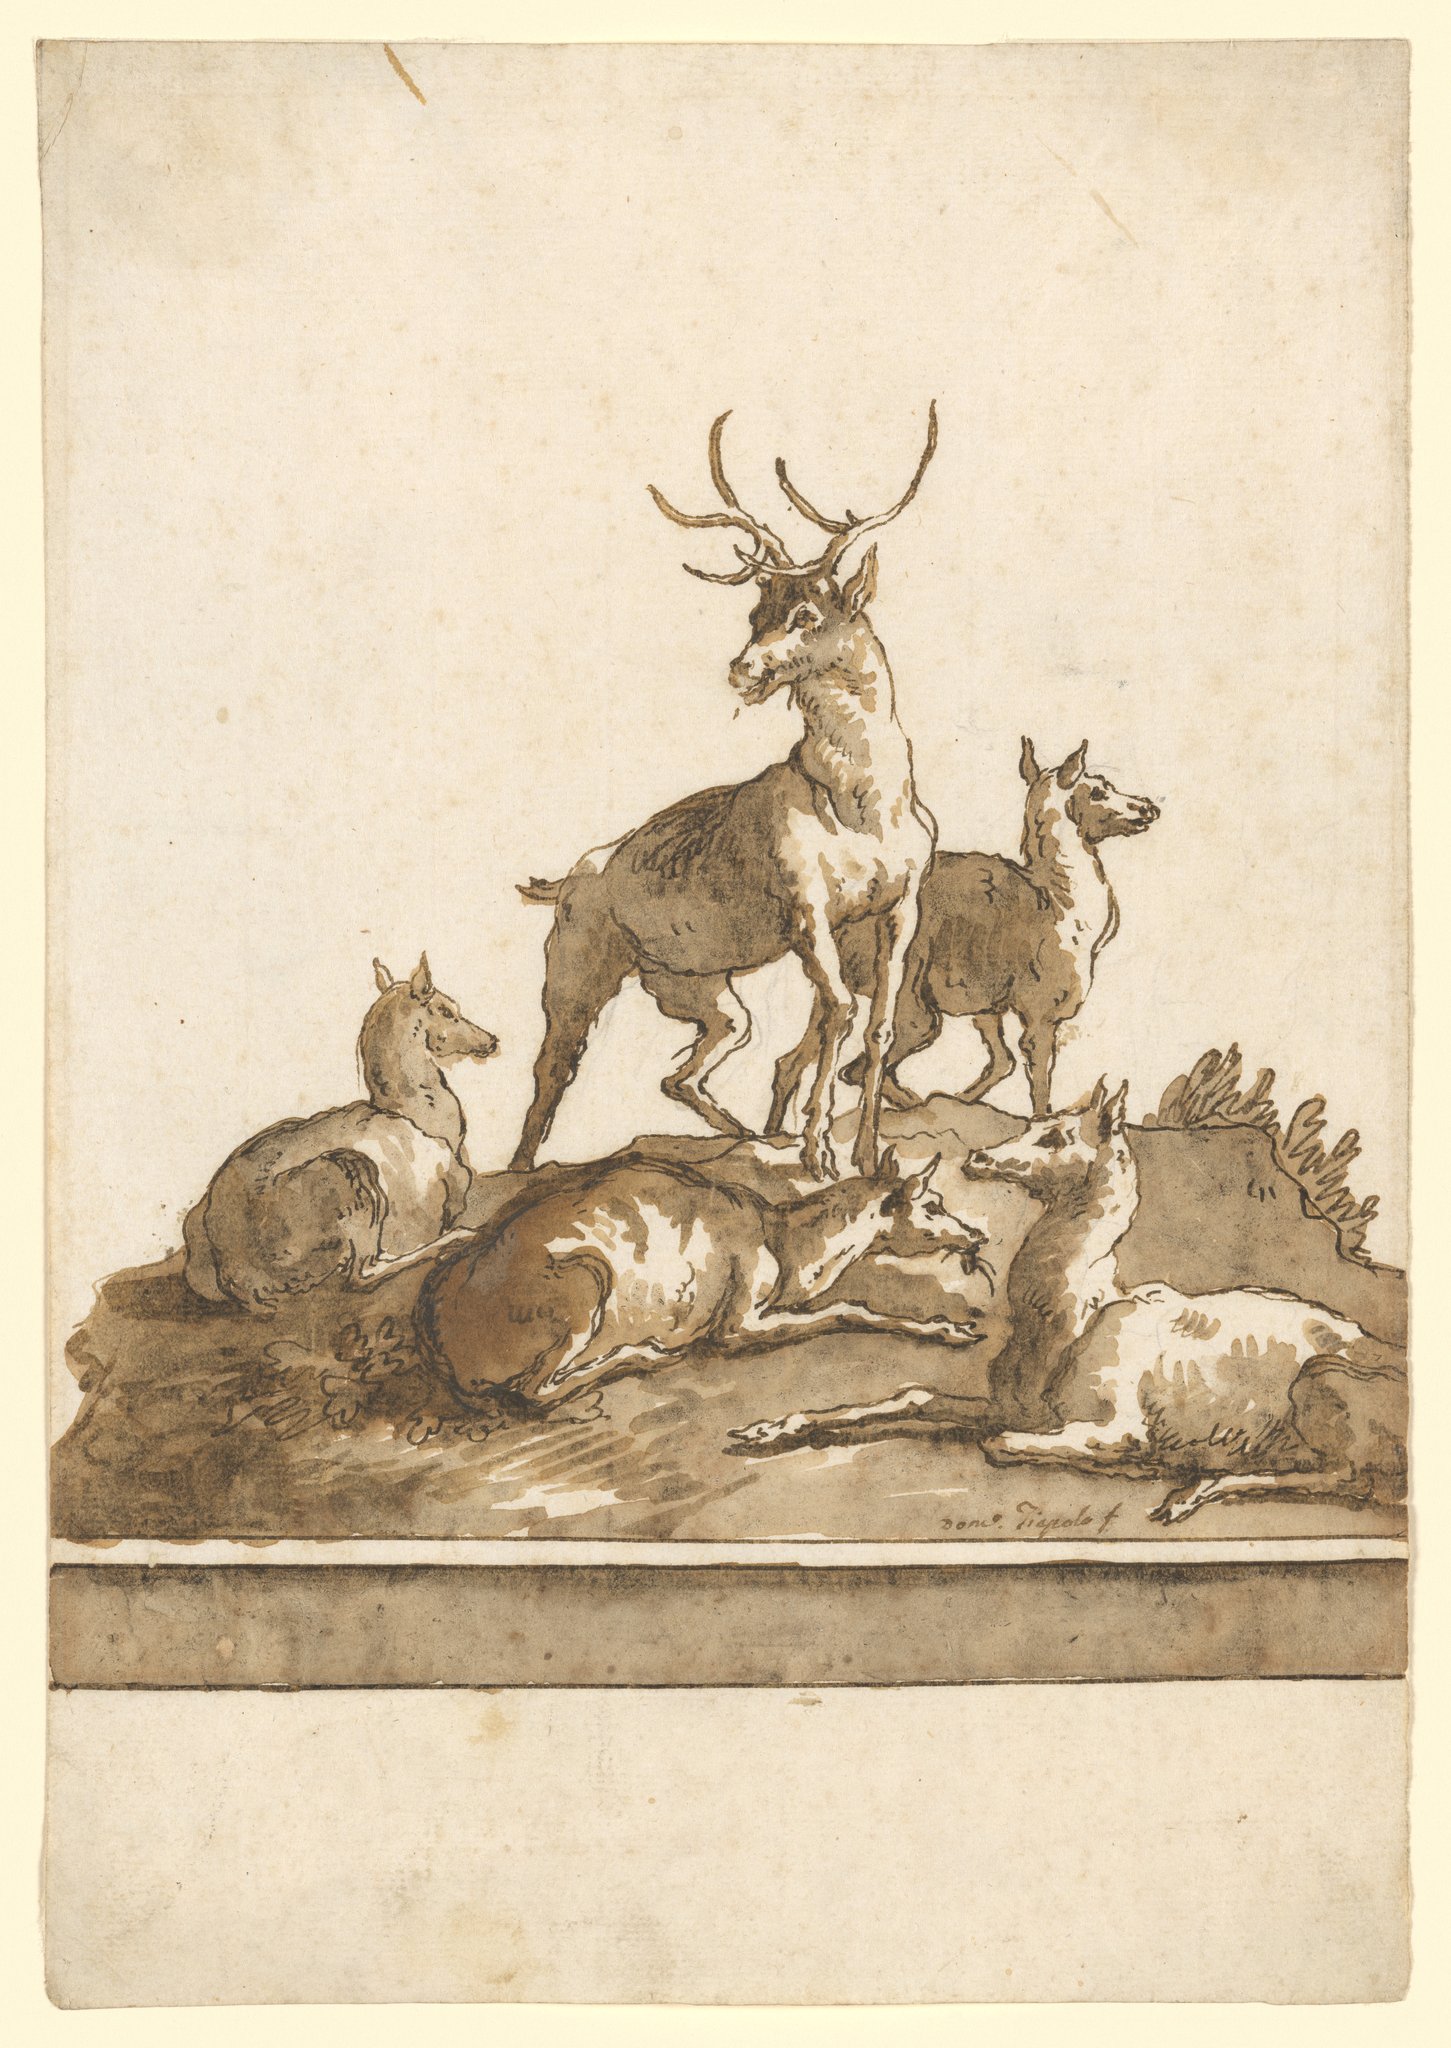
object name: drawing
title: A Stag and Four Hinds on a Grassy Knoll (with Base)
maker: giovanni domenico tiepolo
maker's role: artist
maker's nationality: italian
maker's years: 1727-1804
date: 1770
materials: chalk, ink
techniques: pen, wash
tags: deer